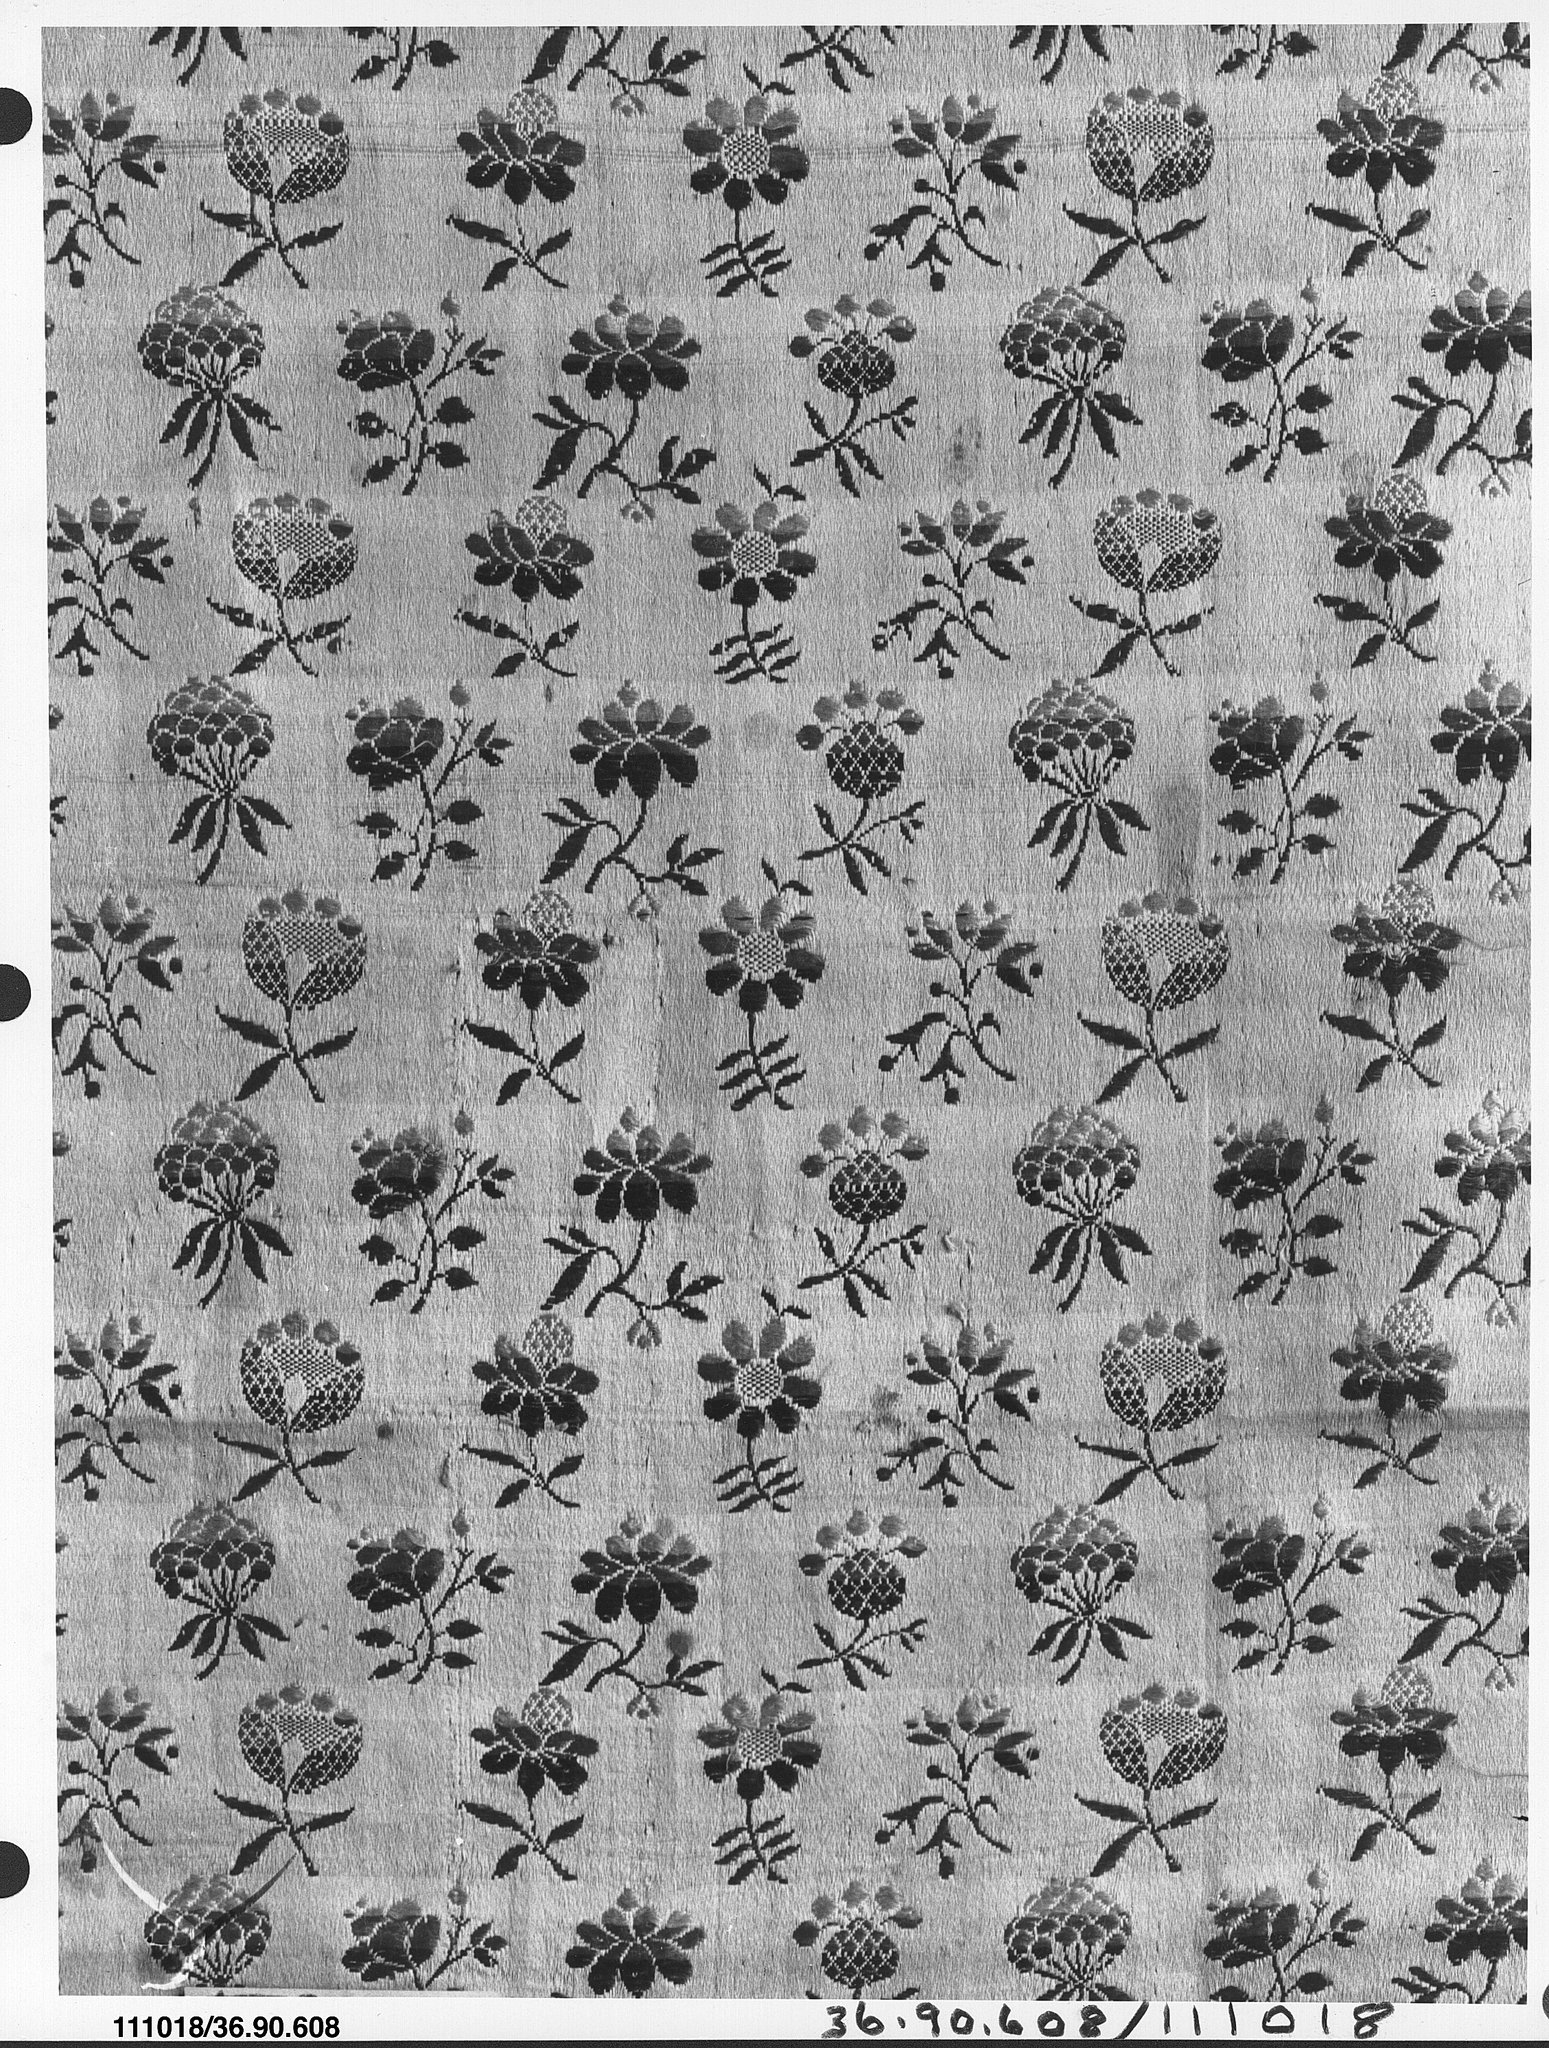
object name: piece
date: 1770-1780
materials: silk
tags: flowers